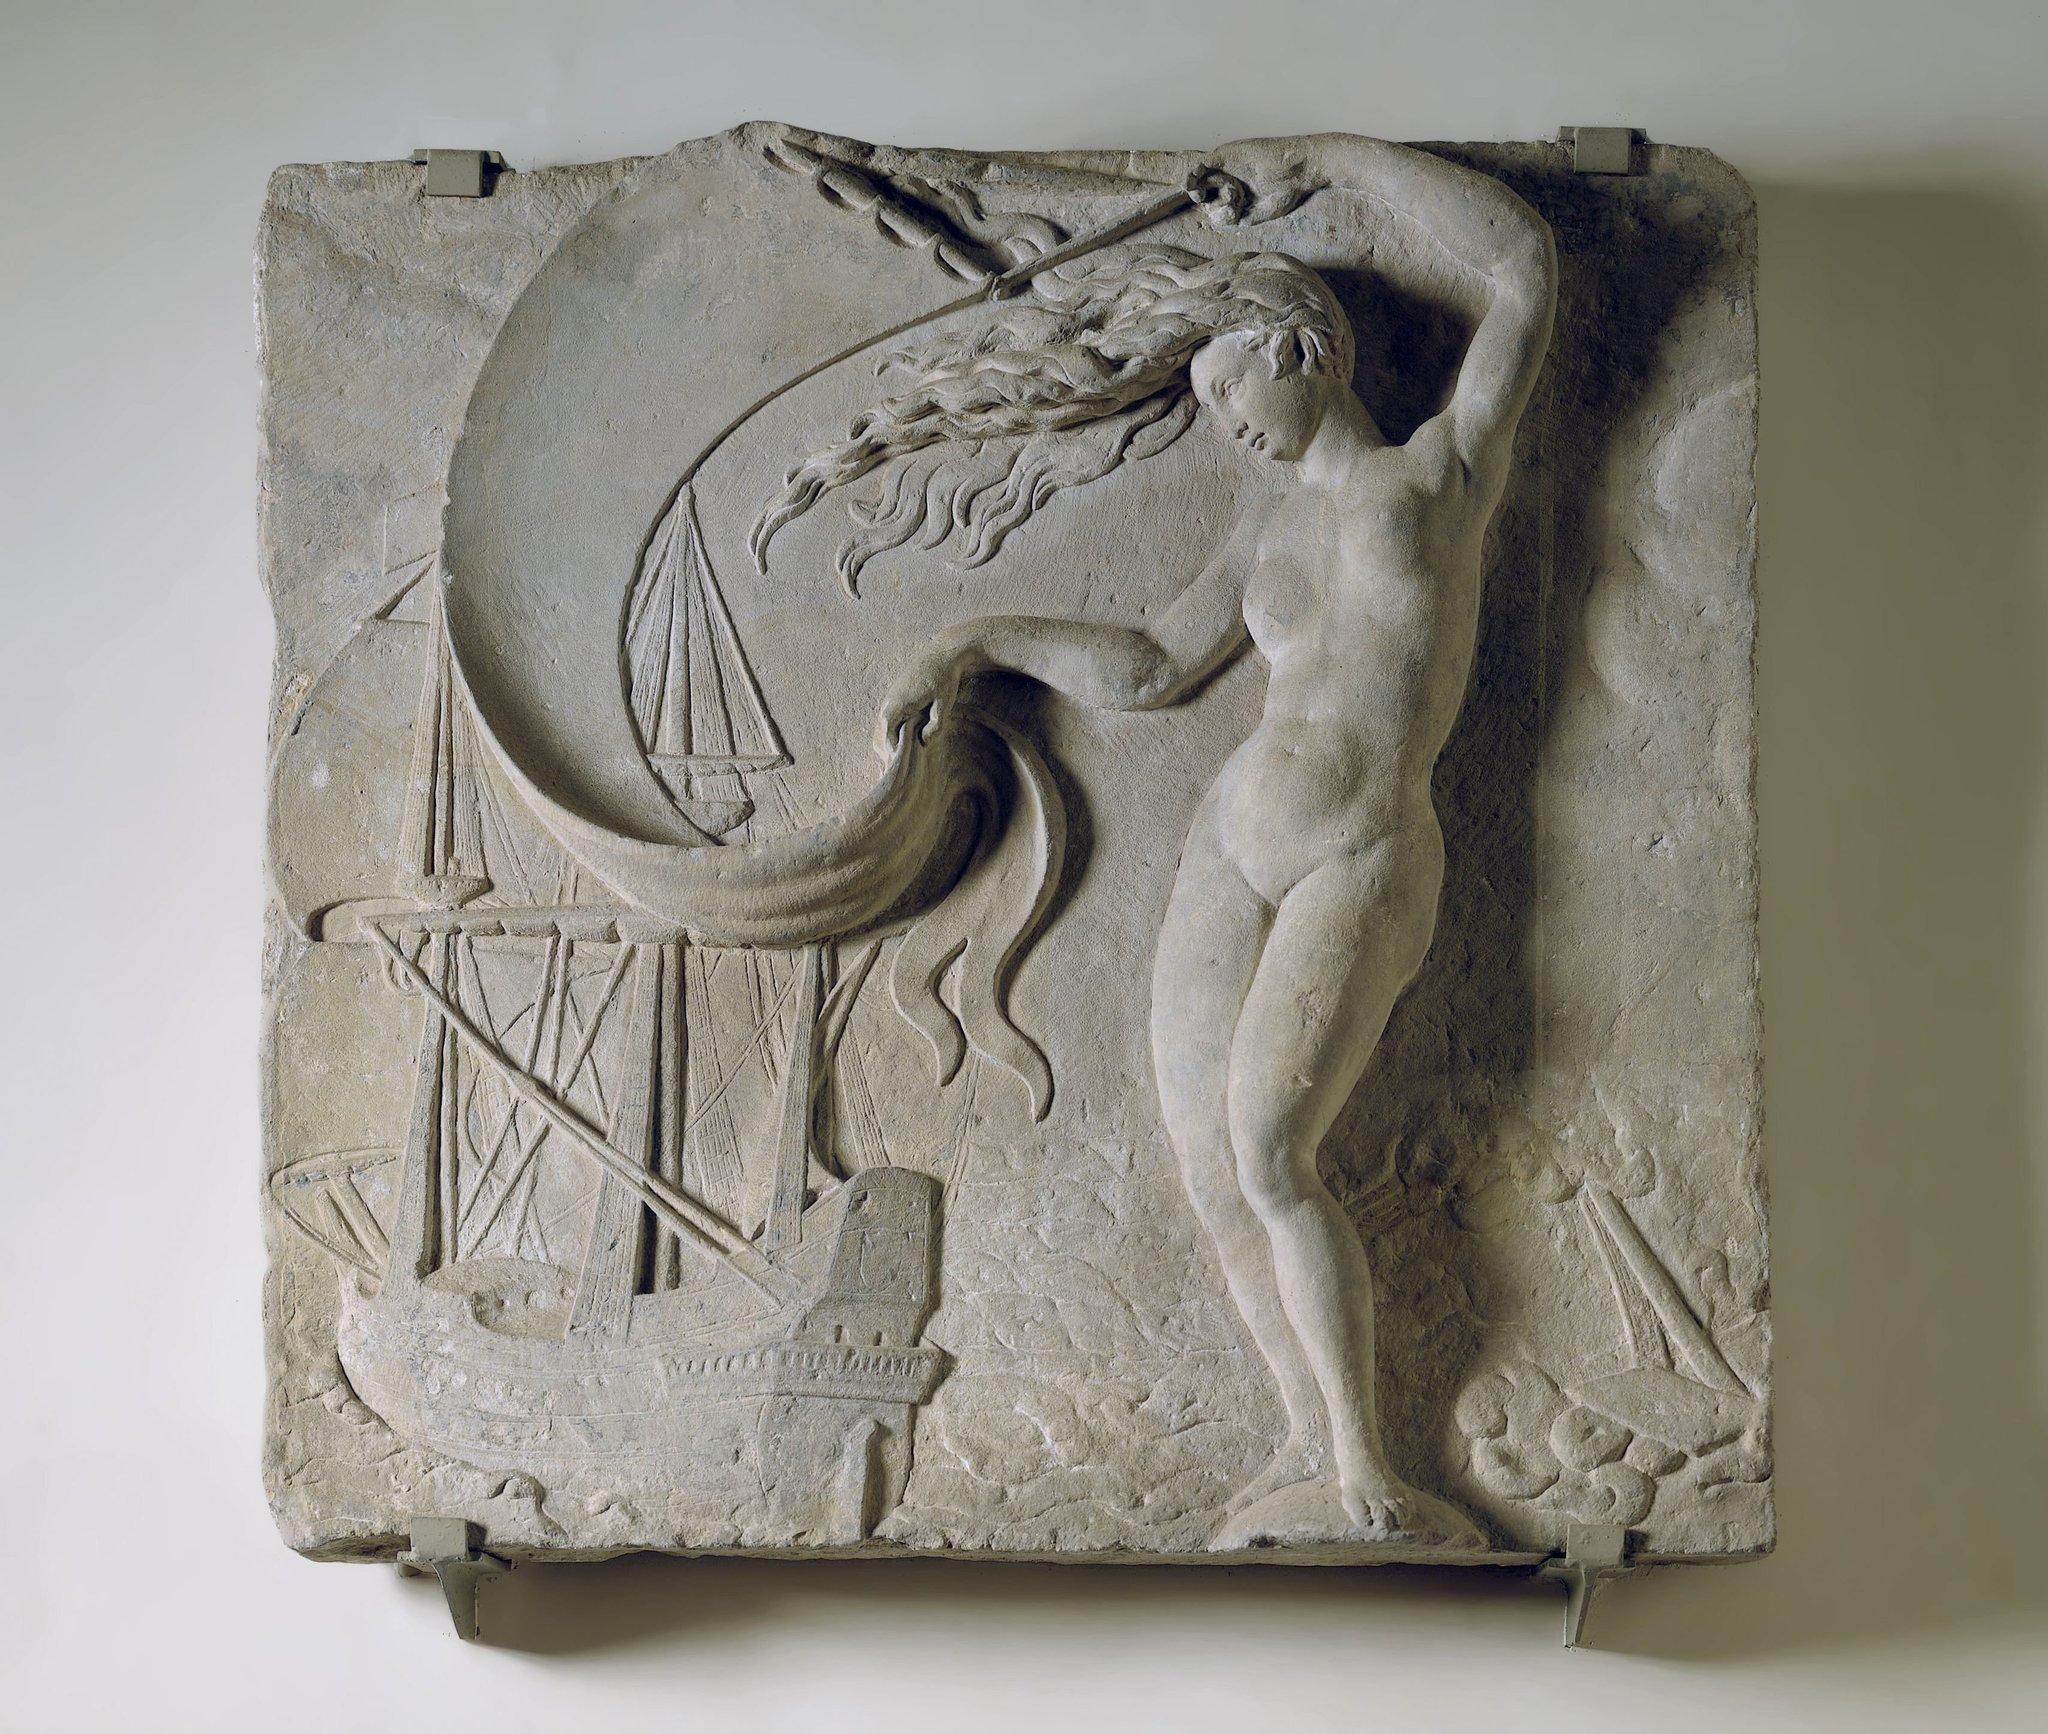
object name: gable stone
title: Fortuna, Stone Tablet from a Facade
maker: hendrick de keyser (i)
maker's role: print maker, sculptor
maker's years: 1565-1621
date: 1610-1620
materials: stone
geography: amsterdam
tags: sailing-ship, sailing-boat, shipwreck, luck, fortune, lot; 'fato', 'fortuna', 'fortuna aurea', 'fortuna buona', 'fortuna pacifica overo clemente', 'sorte' (ripa)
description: Attributed to Hendrick de Keyser (1565-1621). Tablet with Dame Fortune. Sandstone. Netherlands, c. 1600-1620.